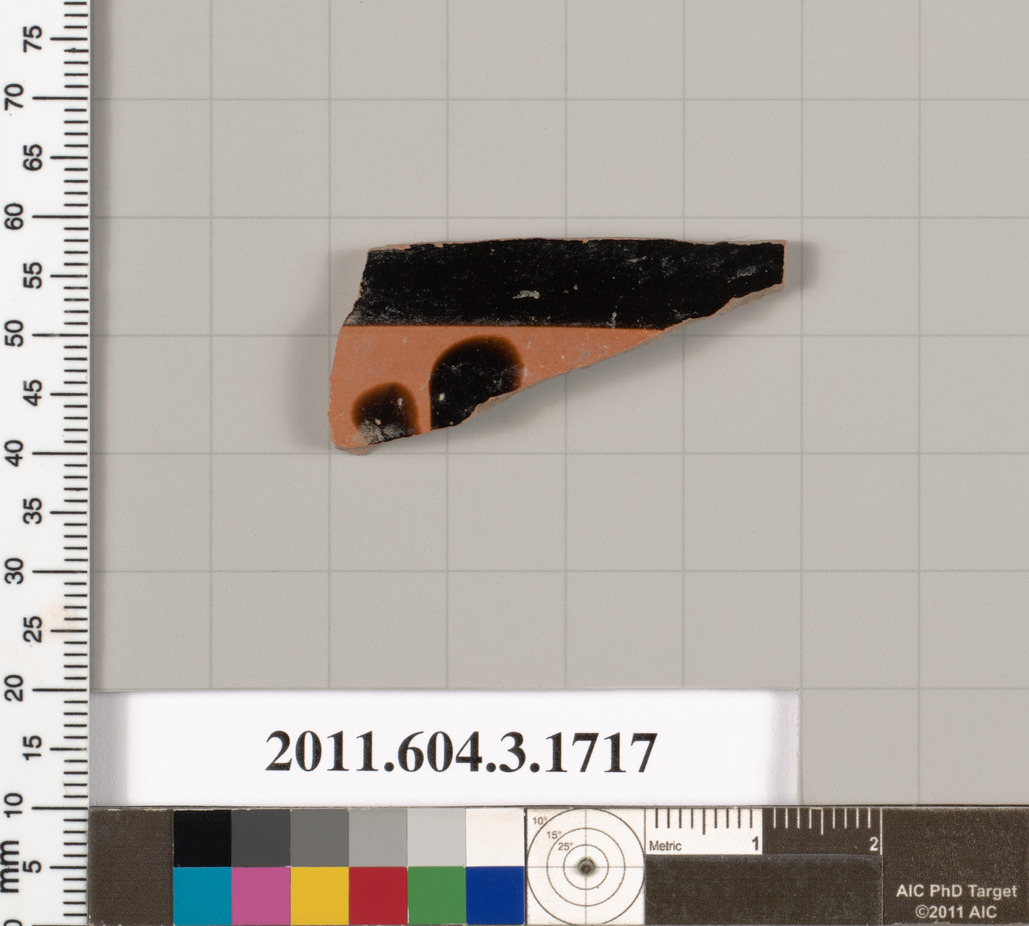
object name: kylix fragment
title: Terracotta rim fragment of a kylix: Band cup (drinking cup)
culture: greek, attic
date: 550-526 BCE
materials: terracotta